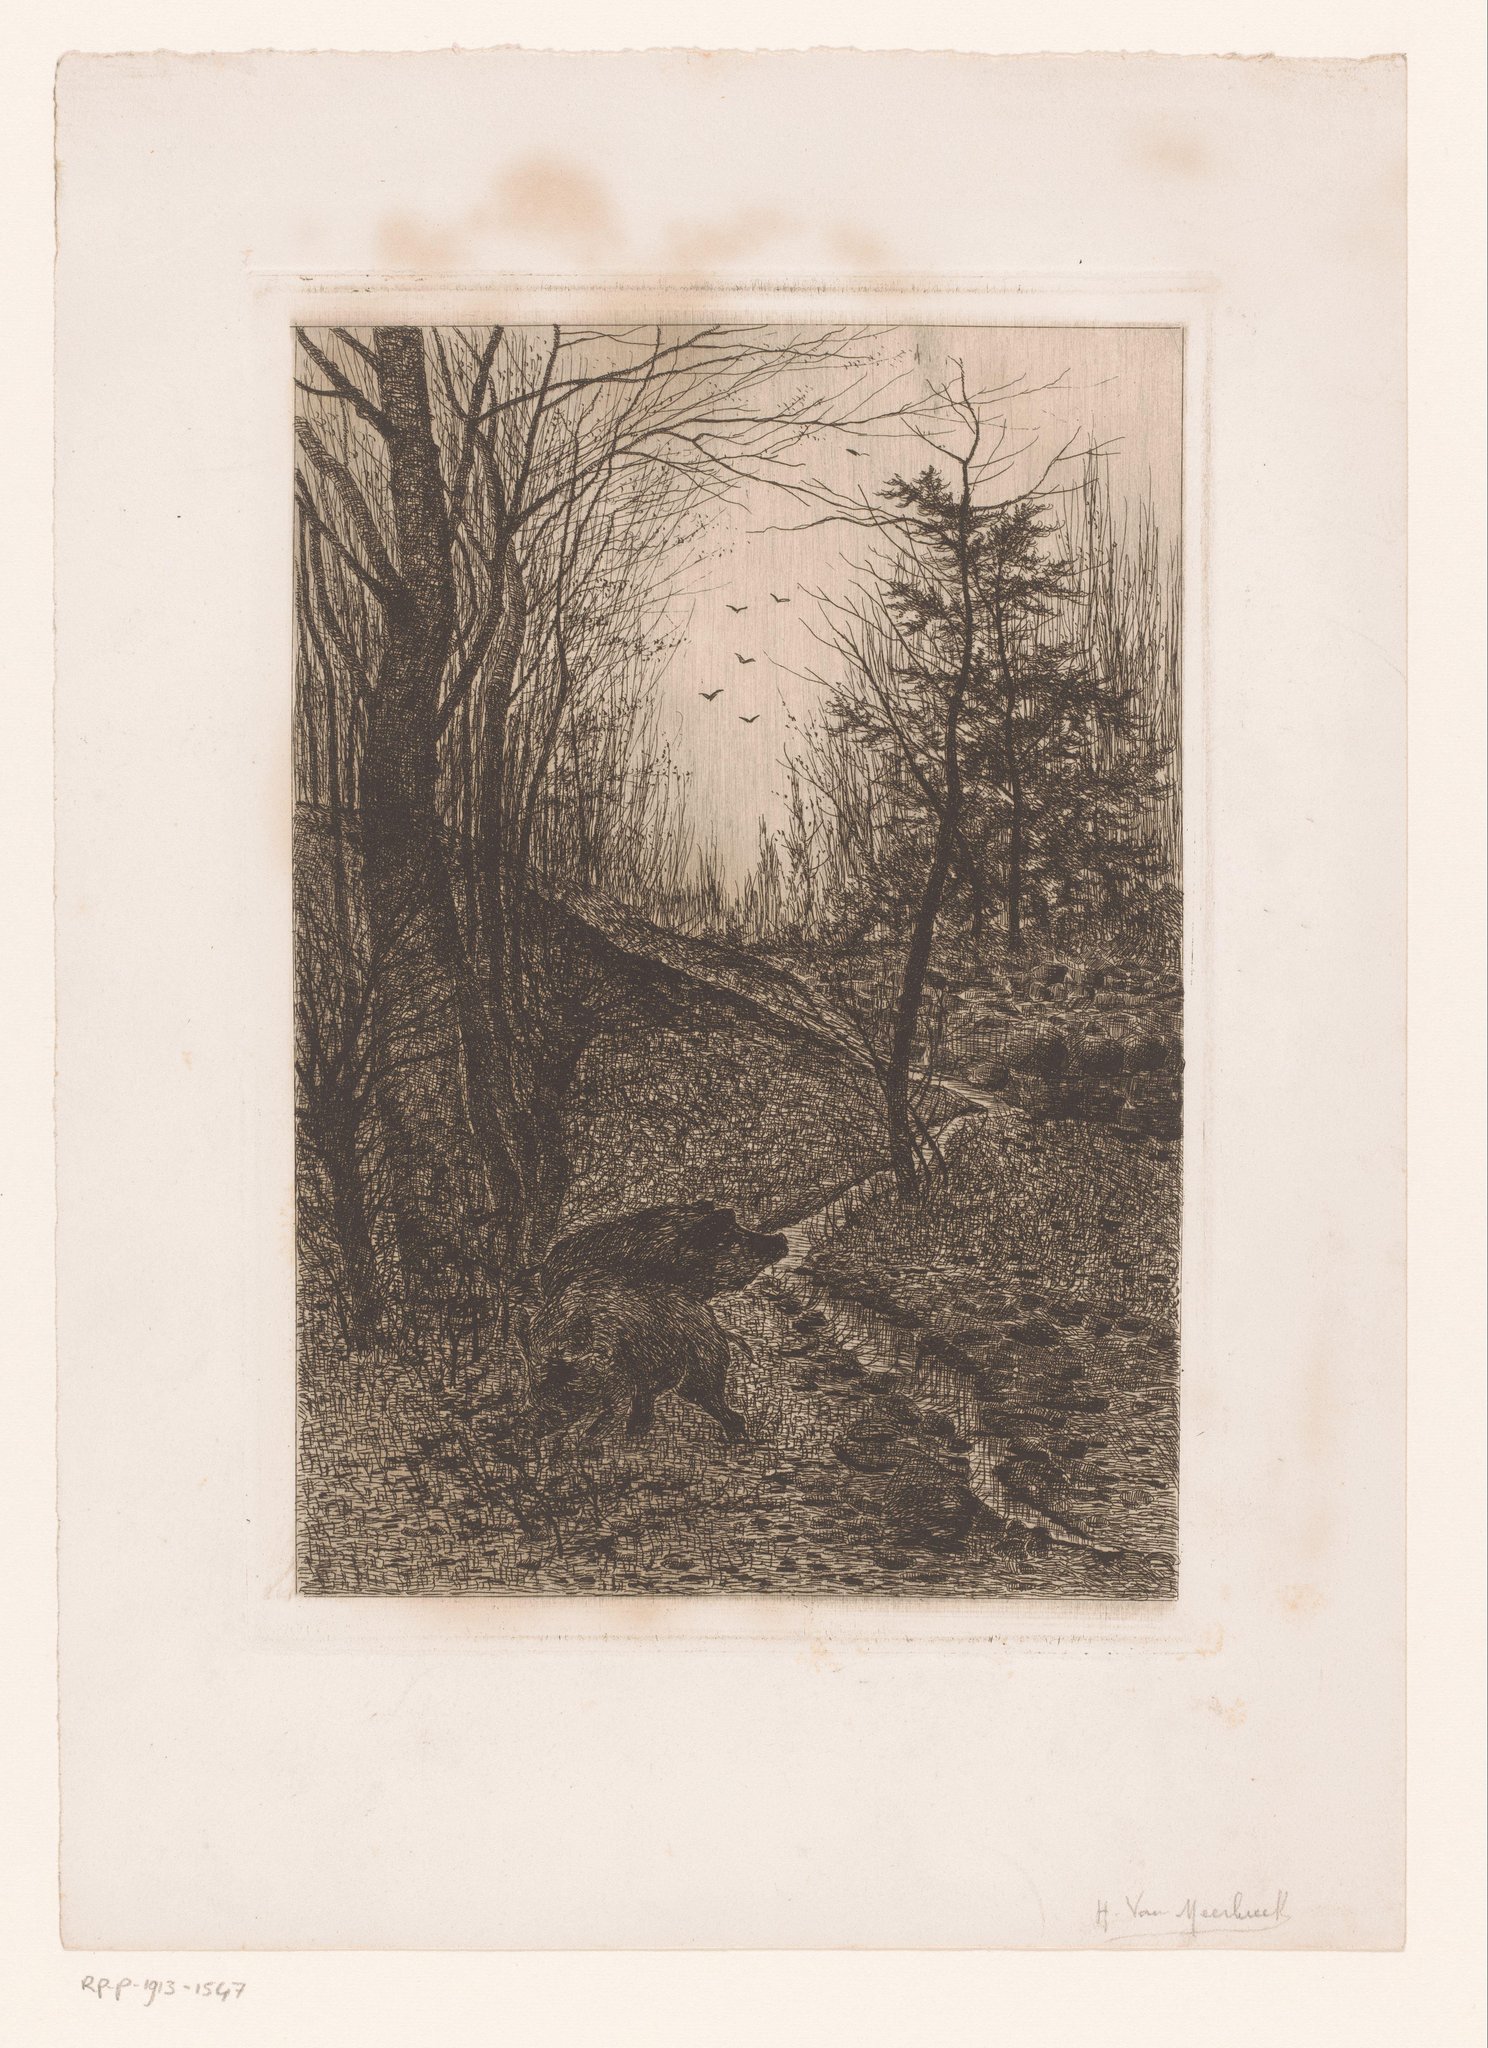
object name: print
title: Landschap met twee wilde zwijnen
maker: h. van meerbeeck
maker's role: print maker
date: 1850-1913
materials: paper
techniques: etching, intaglio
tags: pig, water course, forest, wood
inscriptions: collector's mark: Lugt 2228